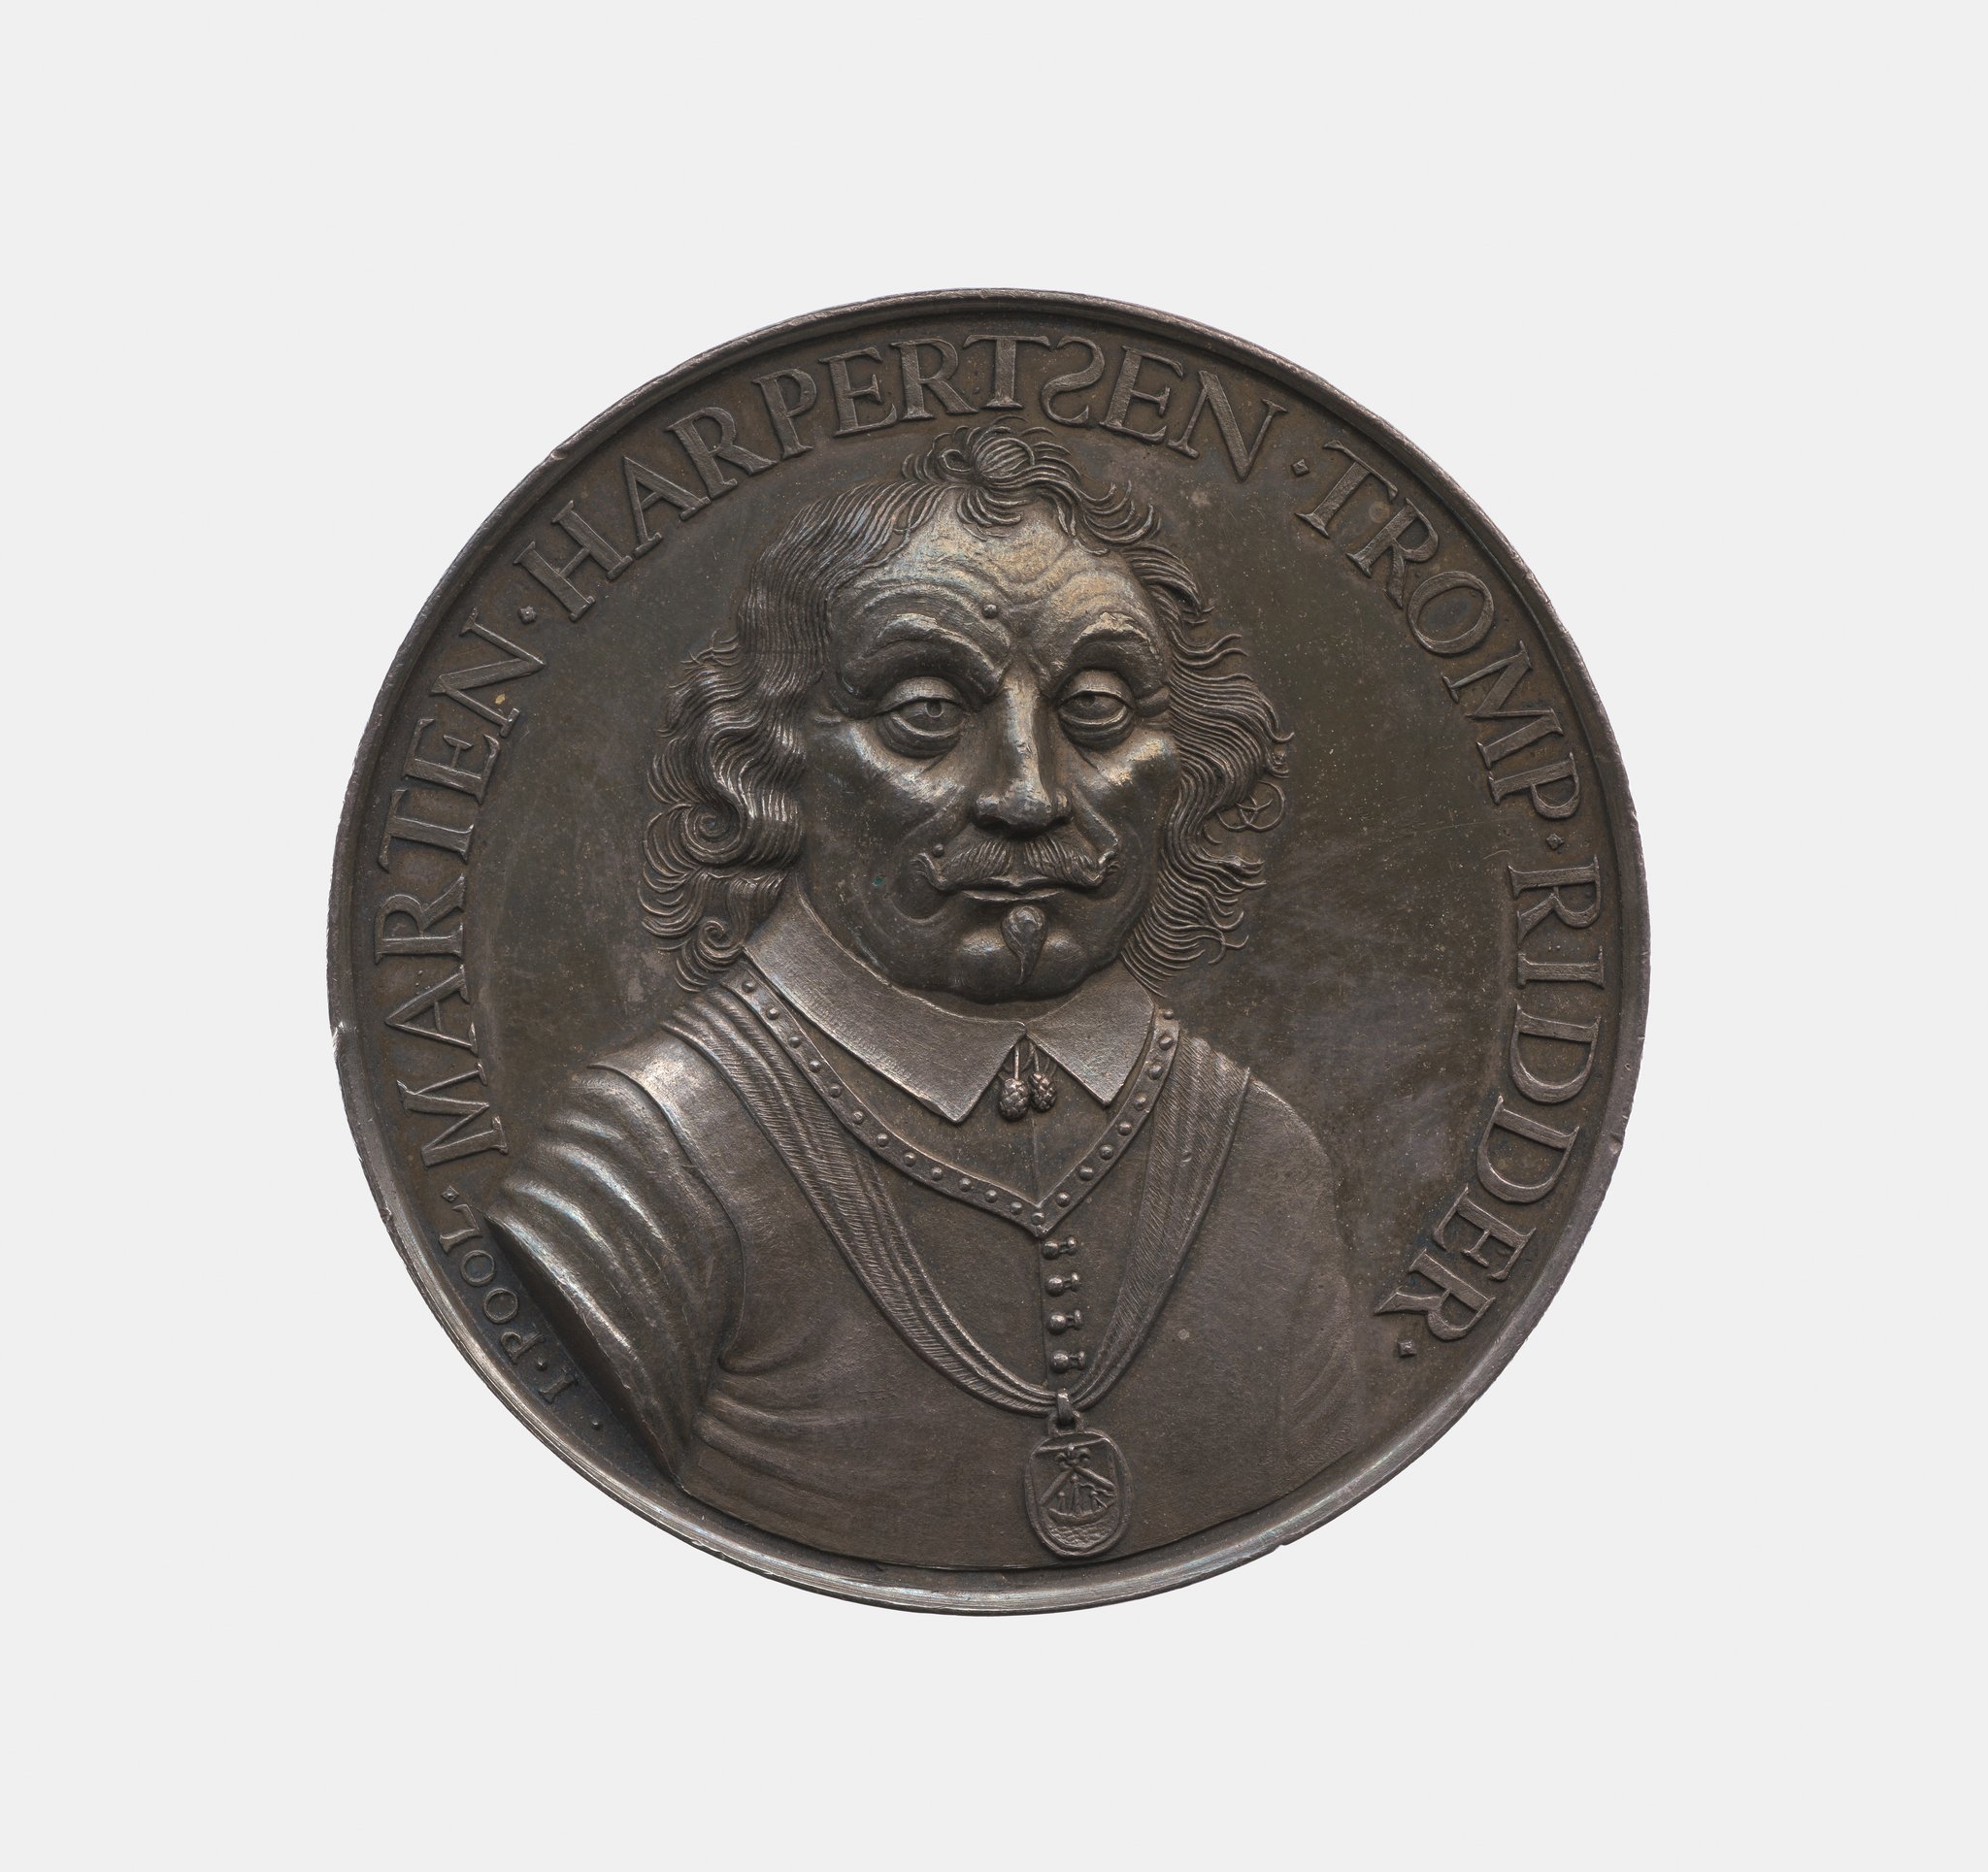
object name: medal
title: Admiral Martin Harpertszoon Tromp 1597-1653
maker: jurriaen i pool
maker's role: engraver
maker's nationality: dutch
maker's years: 1618-1699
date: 1653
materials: silver